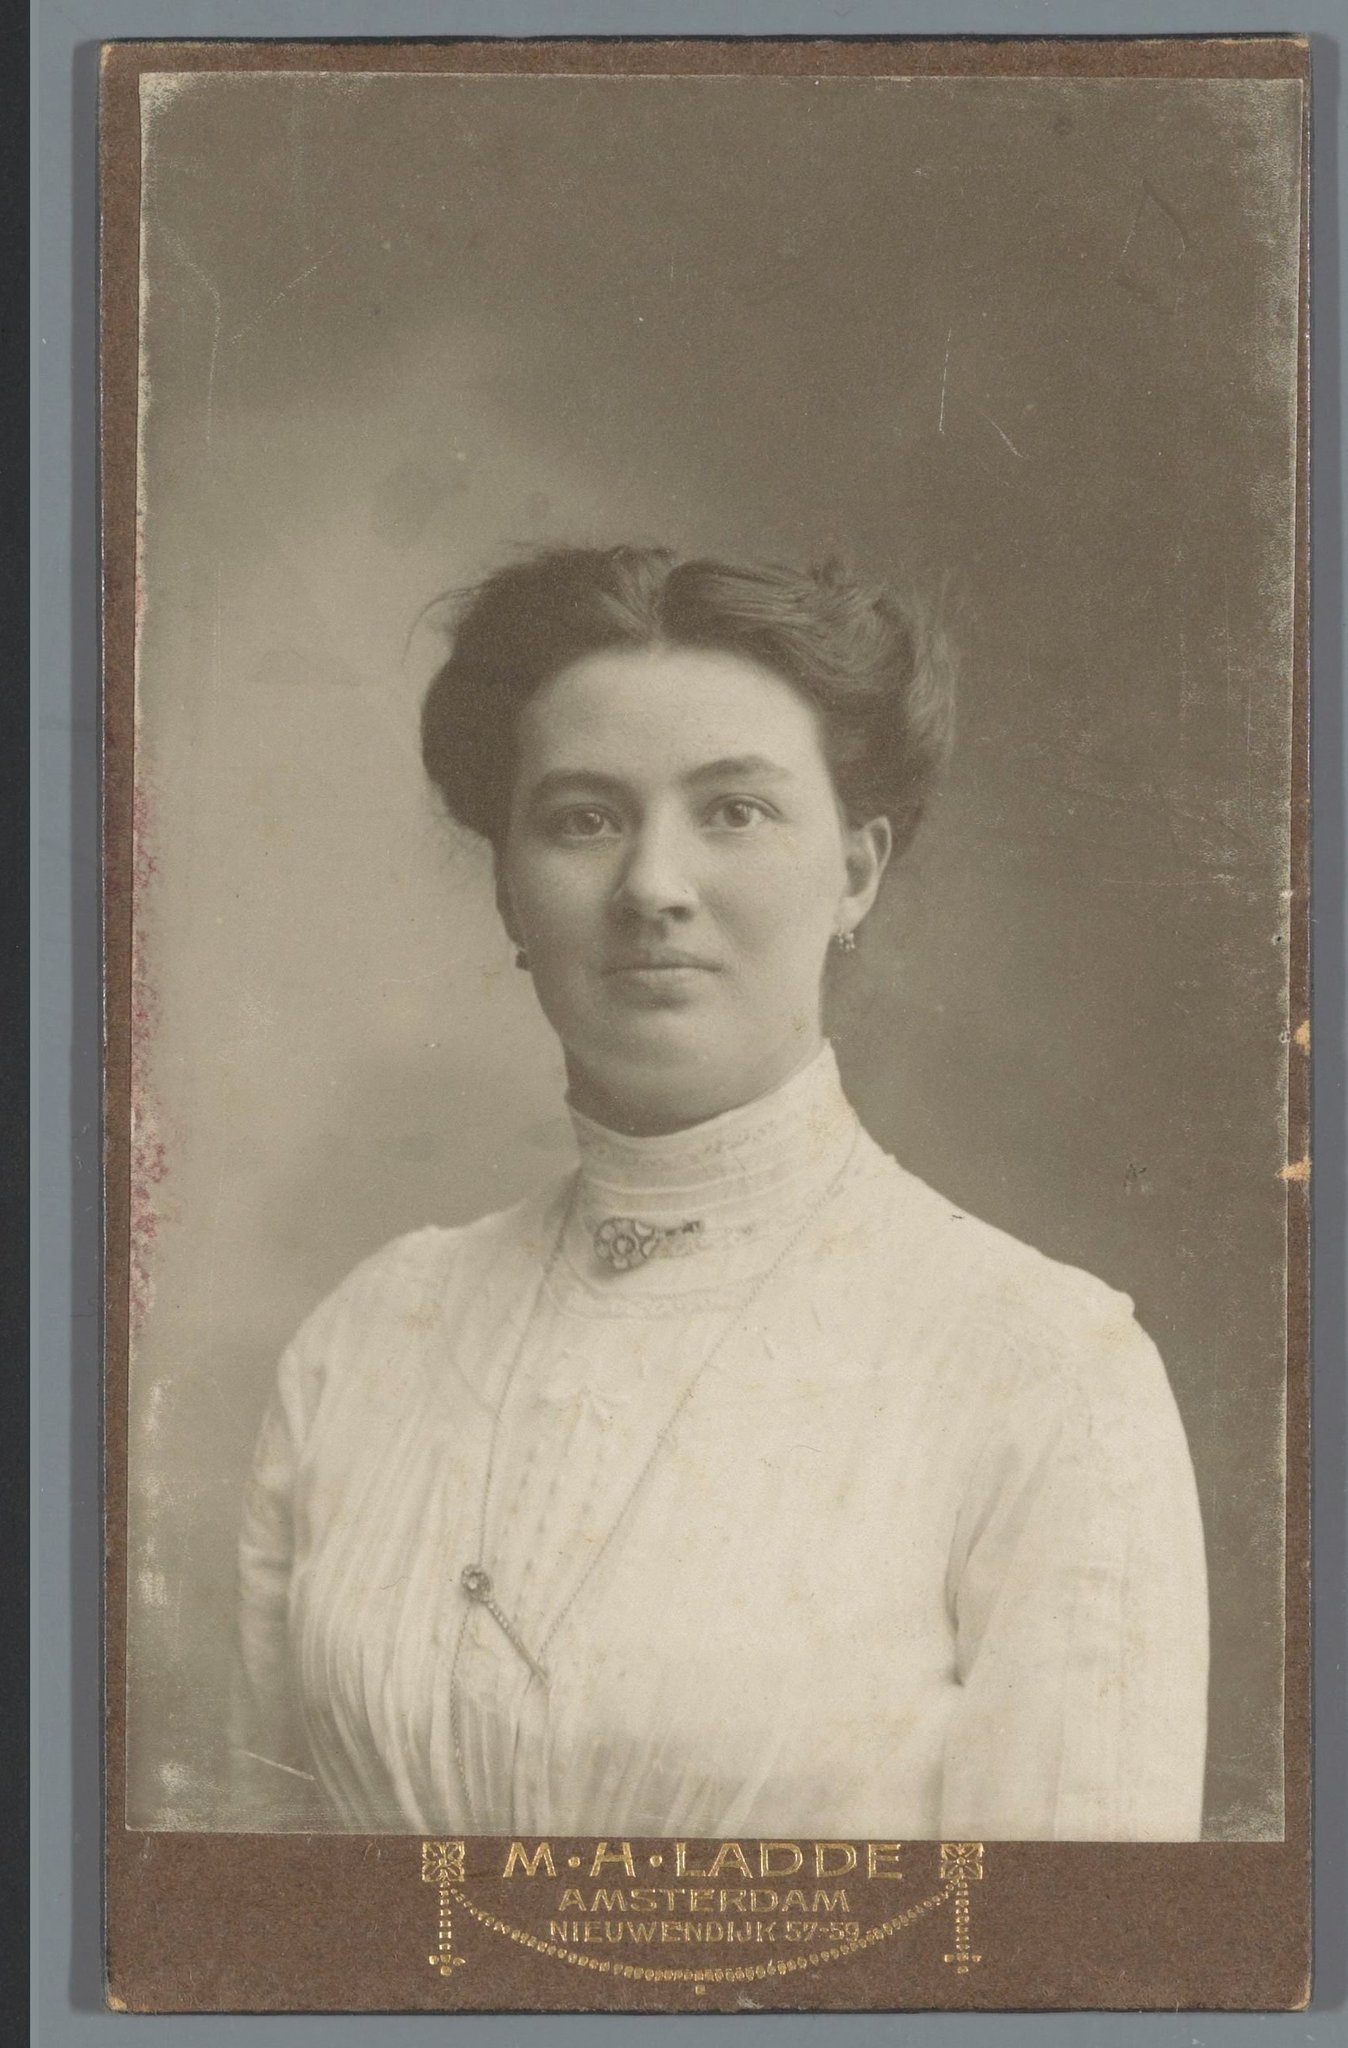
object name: photograph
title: Portret van een onbekende vrouw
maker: machiel hendricus laddé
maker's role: fotograaf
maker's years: 1866-1932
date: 1892-1906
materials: cardboard, photographic support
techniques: matte daylight collodion silver print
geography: amsterdam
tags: historical persons - bb - woman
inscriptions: address: ‘M. H. LADDE/ AMSTERDAM/ NIEUWENDIJK 57-59’